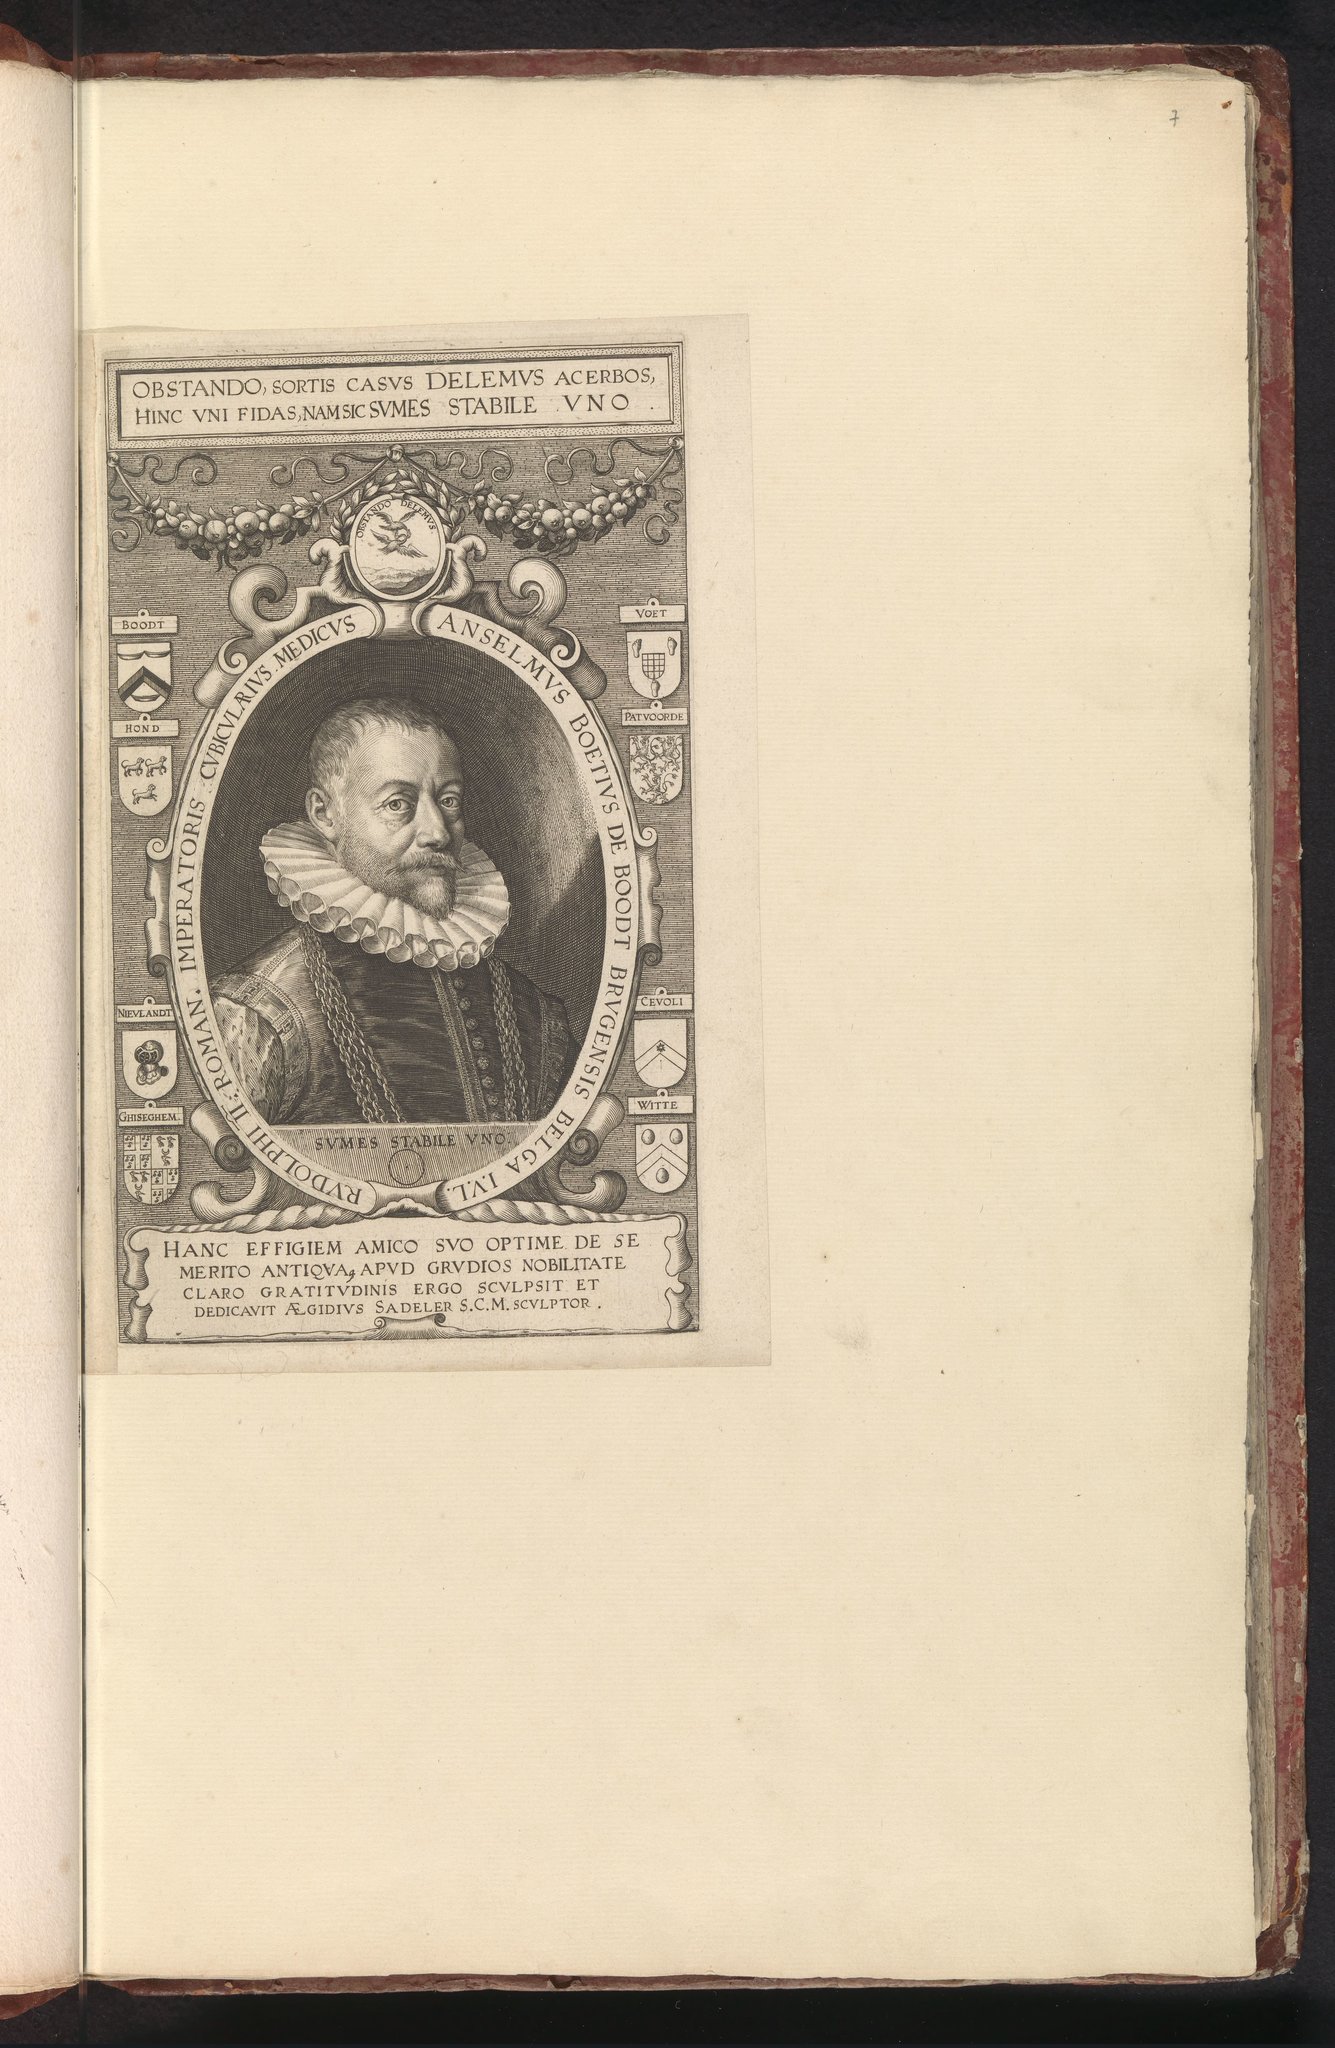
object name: print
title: Portret van Anselmus Boëtius de Boodt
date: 1597-1629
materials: ink, paper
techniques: engraving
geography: prague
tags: bruges, draughtsman, anselmus boëtius de boodt, armorial bearing, heraldry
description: Portret van Anselmus Boëtius de Boodt, lijfarts van Rudolf II. Rondom het portret verschillende wapenschilden en een Latijns opschrift, randschrift en onderschrift met naam en functie. Onderdeel van het eerste album met tekeningen van viervoeters. Eerste van twaalf albums met tekeningen van dieren, vogels en planten bekend rond 1600, gemaakt in opdracht van keizer Rudolf II. Met toelichting in Nederlands, Latijn en Frans.